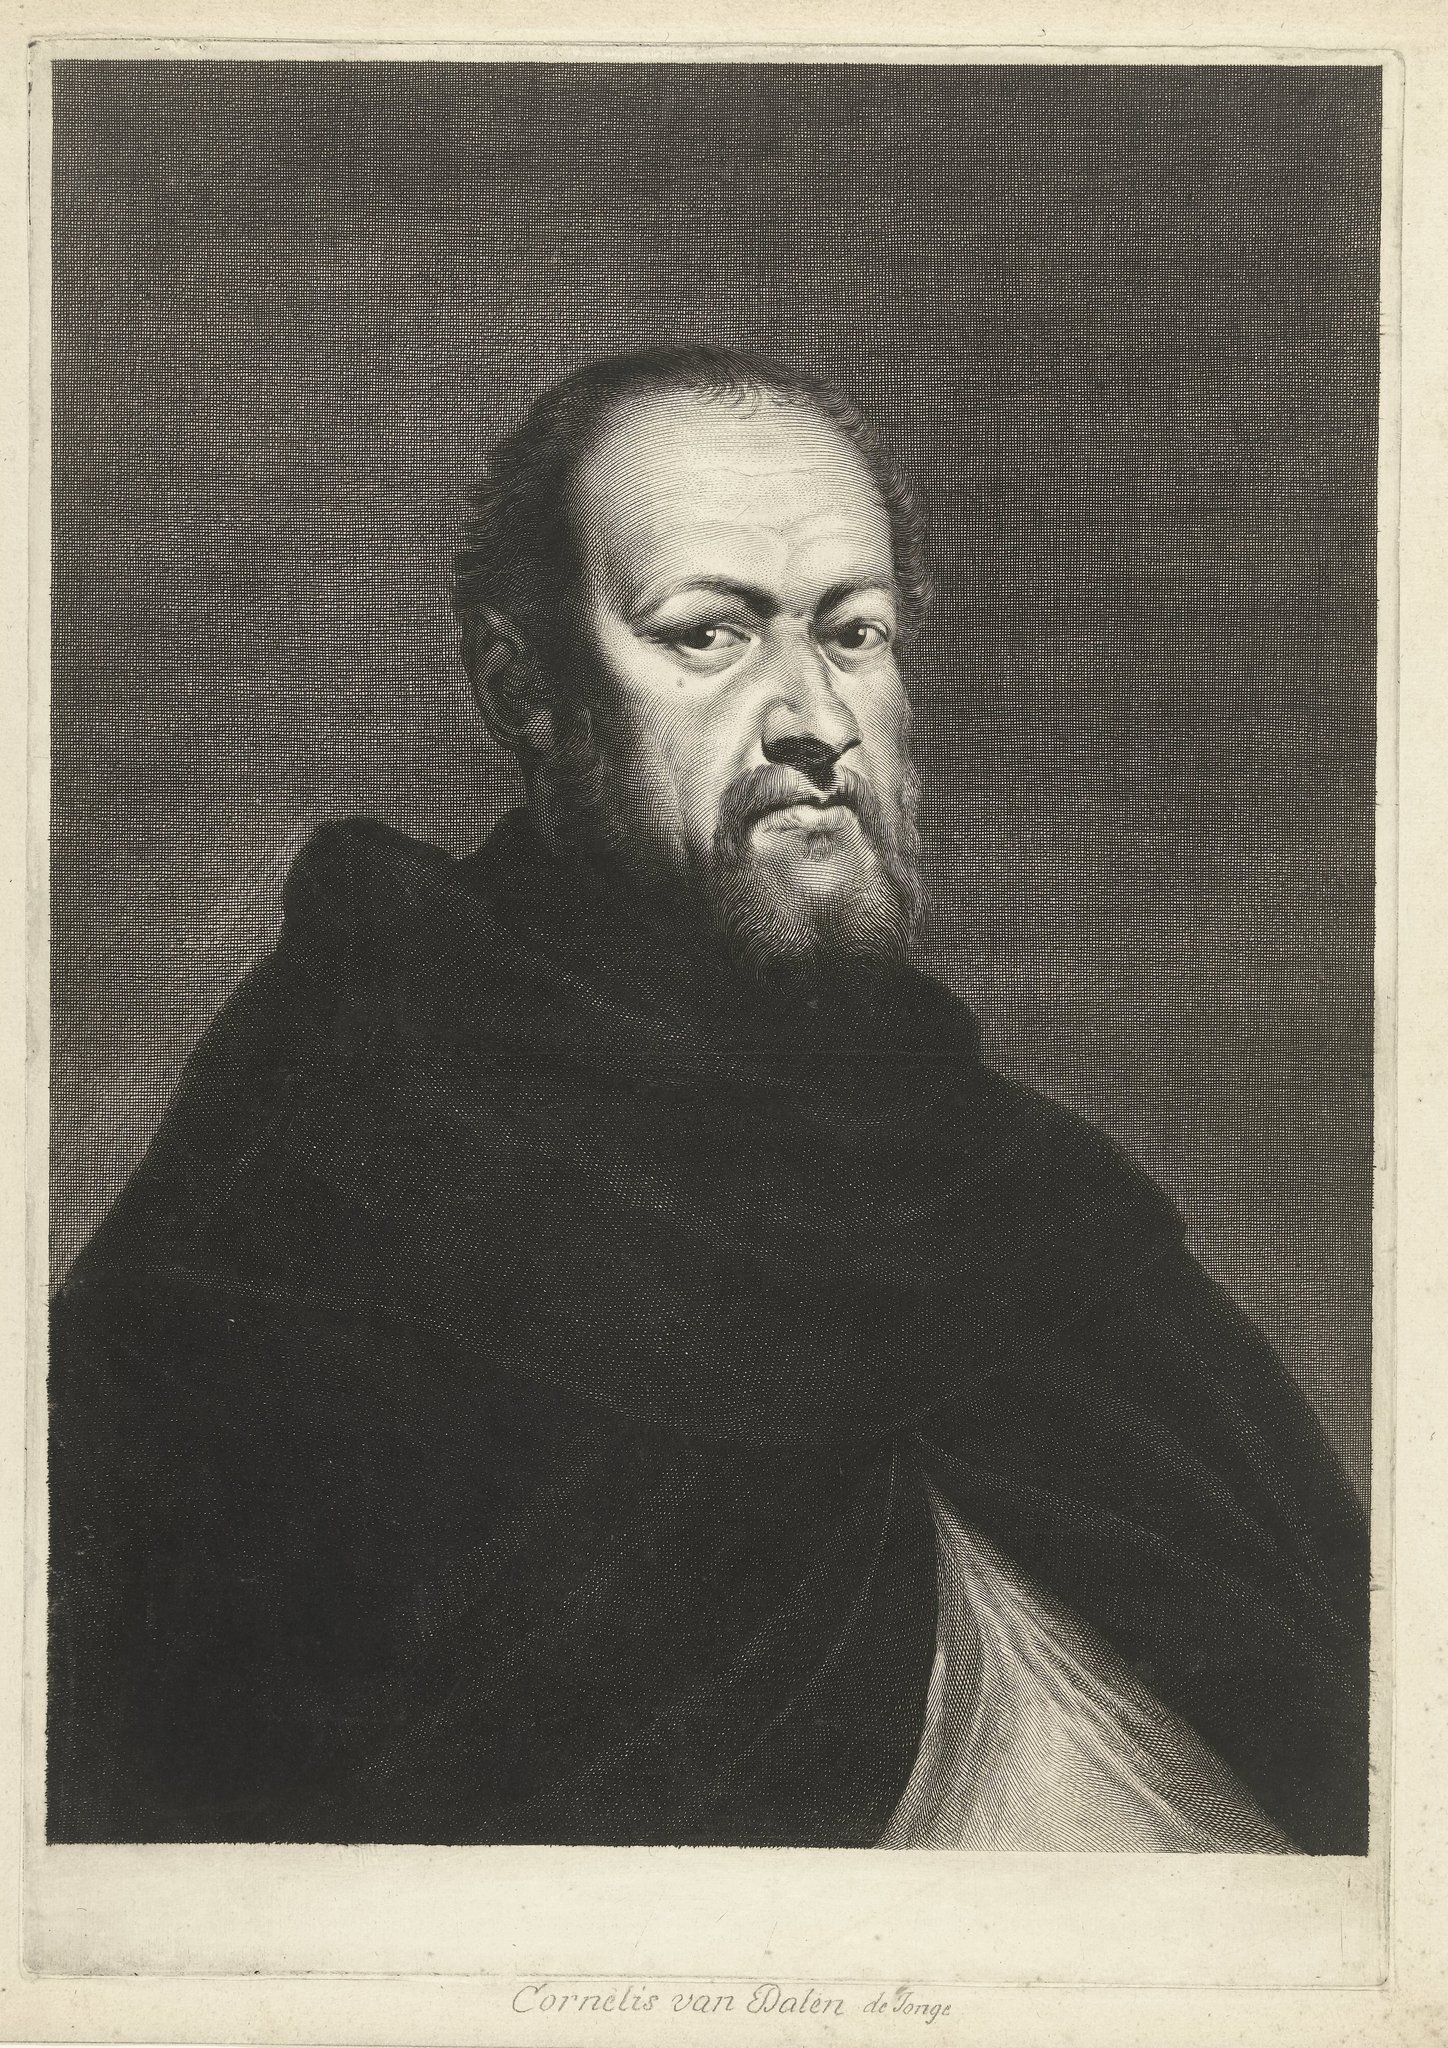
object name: print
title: Caelaturae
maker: cornelis van dalen (ii)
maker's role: draughtsman, print maker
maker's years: 1638-1664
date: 1648-1664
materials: paper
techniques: engraving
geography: amsterdam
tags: venice, rome, painter, draughtsman, sebastiano del piombo, portrait, self-portrait of painter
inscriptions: collector's mark: Lugt 240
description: Prent naar schilderij van Titiaan. Prent uit serie Caelaturae met vierendertig reprodukties naar Italiaanse en Nederlandse schilders, vervaardigd door de allerbeste graveurs in opdracht van de verzamelaar Gerard Reynst. Vergelijk het Reynst album uit de verzameling van Michiel Hinloopen met vier portretten door Cornelis van Dalen (II) in eerste staten in het Rijksmuseum, zie Waals 1988, p. 103, 104.